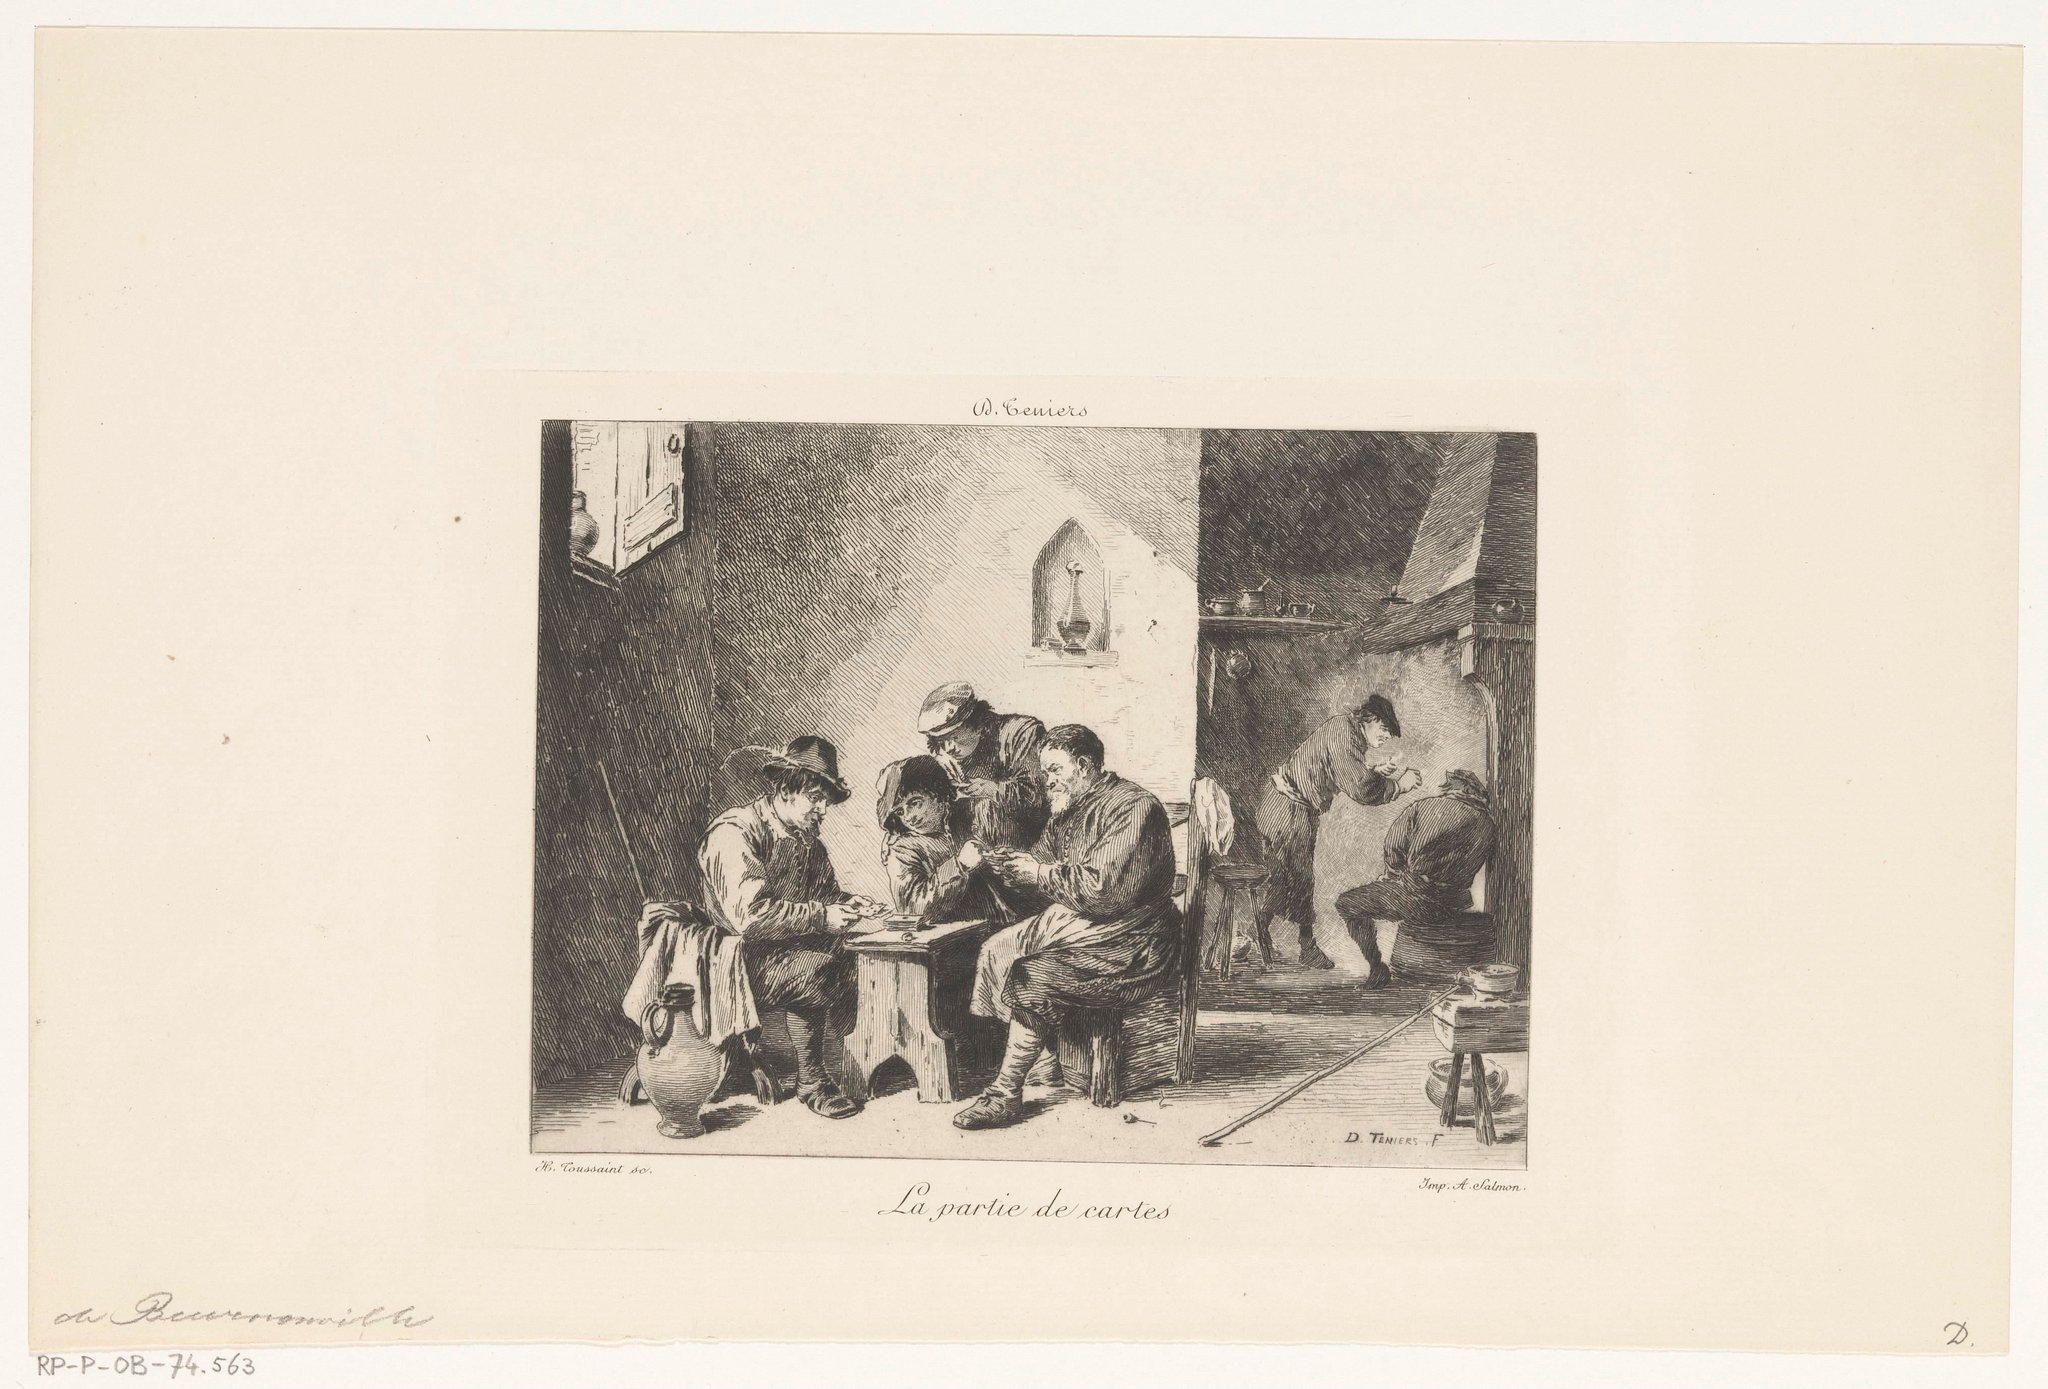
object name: book illustration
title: Herberginterieur met kaartspelers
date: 1881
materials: paper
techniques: etching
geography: paris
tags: playing-cards, hotel, hostelry, inn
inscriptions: collector's mark: Lugt 2228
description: Prent afkomstig uit een veilingcatalogus: "Catalogue des Tableaux anciens composant la très importante collection de Monsieur le Baron de Beurnonville", uitgegeven in 1881 te Parijs door Pillet en Dumoulin. De veiling vond plaats op 9 tot en met 14 en 16 mei 1881. Deze prent betreft een illustratie bij lot 497 op p. 308.